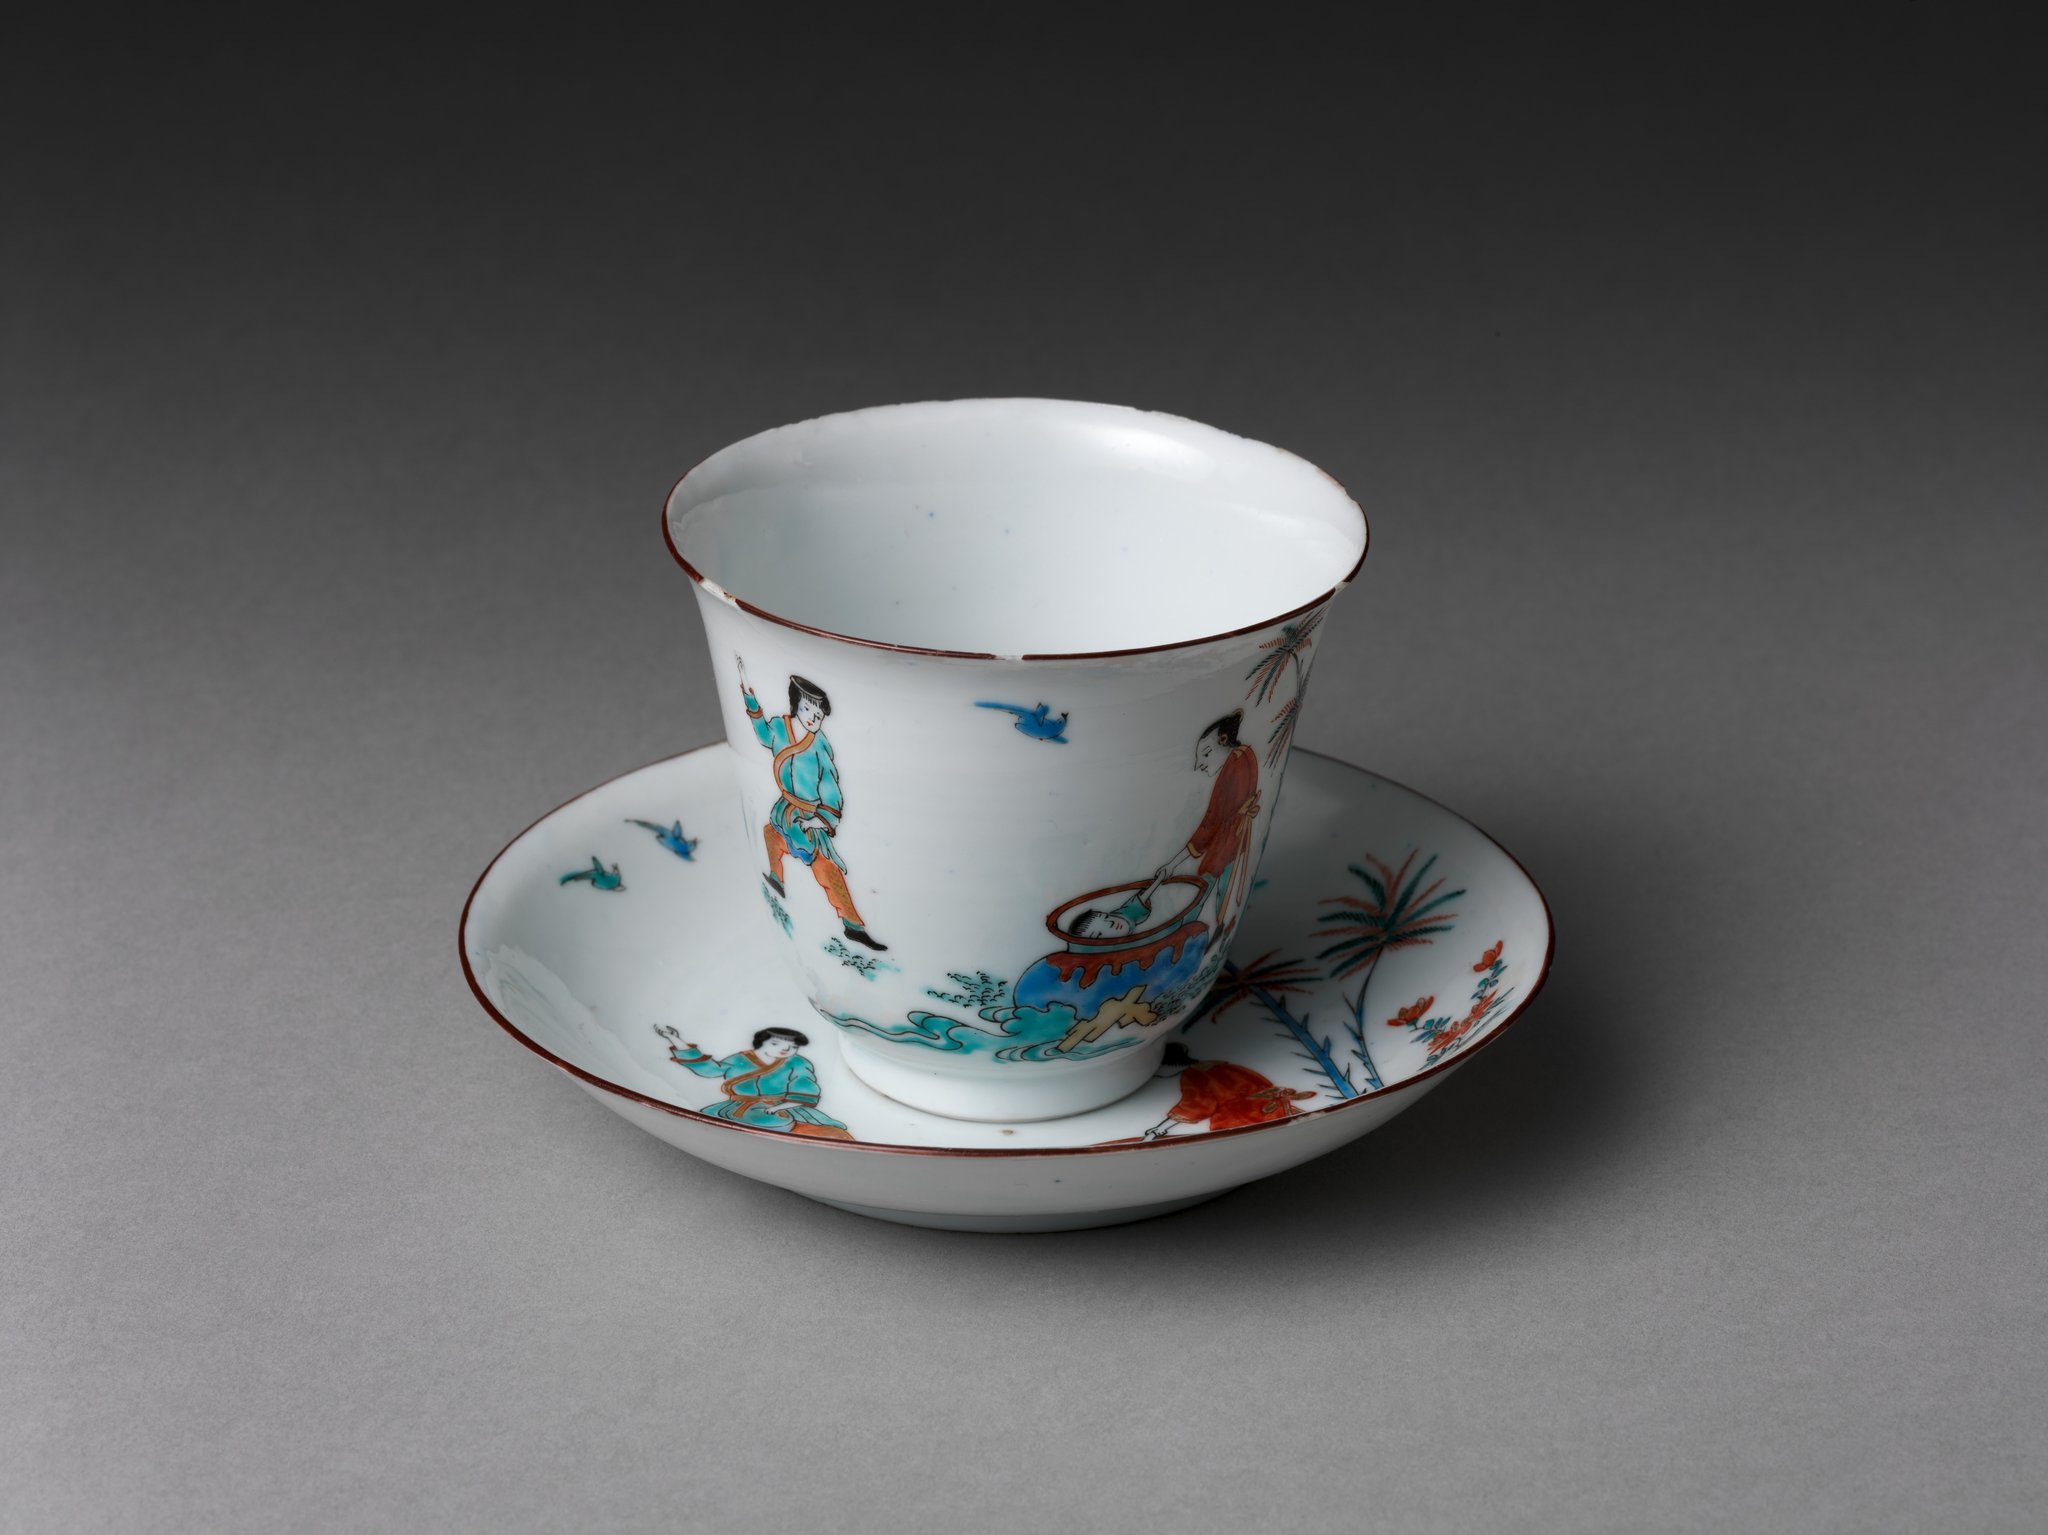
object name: cup and saucer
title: Cup and saucer with the Chinese story of Sima Guang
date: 1700-1730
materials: enamel, glaze, hard paste porcelain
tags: children,men,women